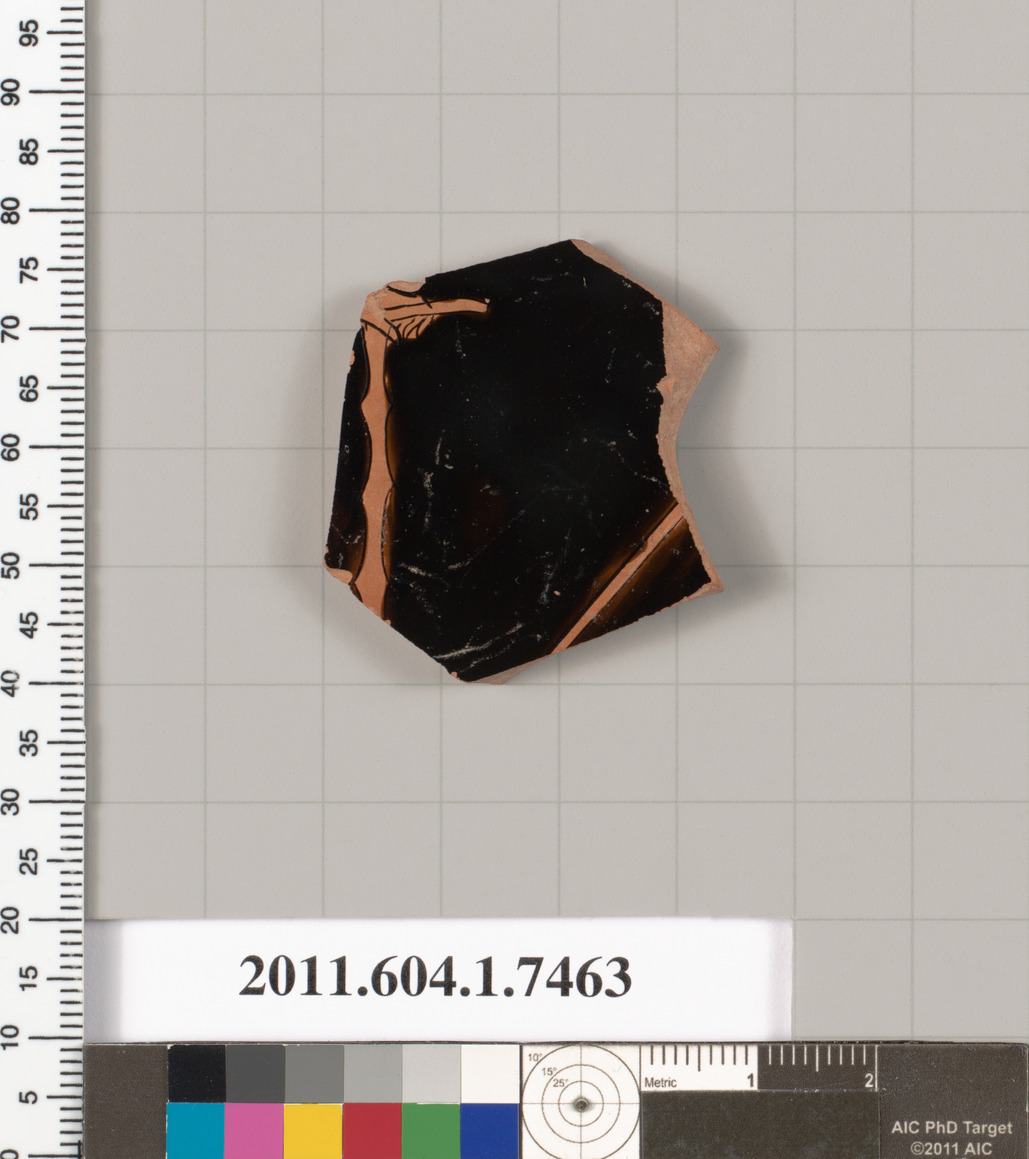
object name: kylix fragment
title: Terracotta fragment of a kylix (drinking cup)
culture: greek, attic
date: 470-460 BCE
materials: terracotta